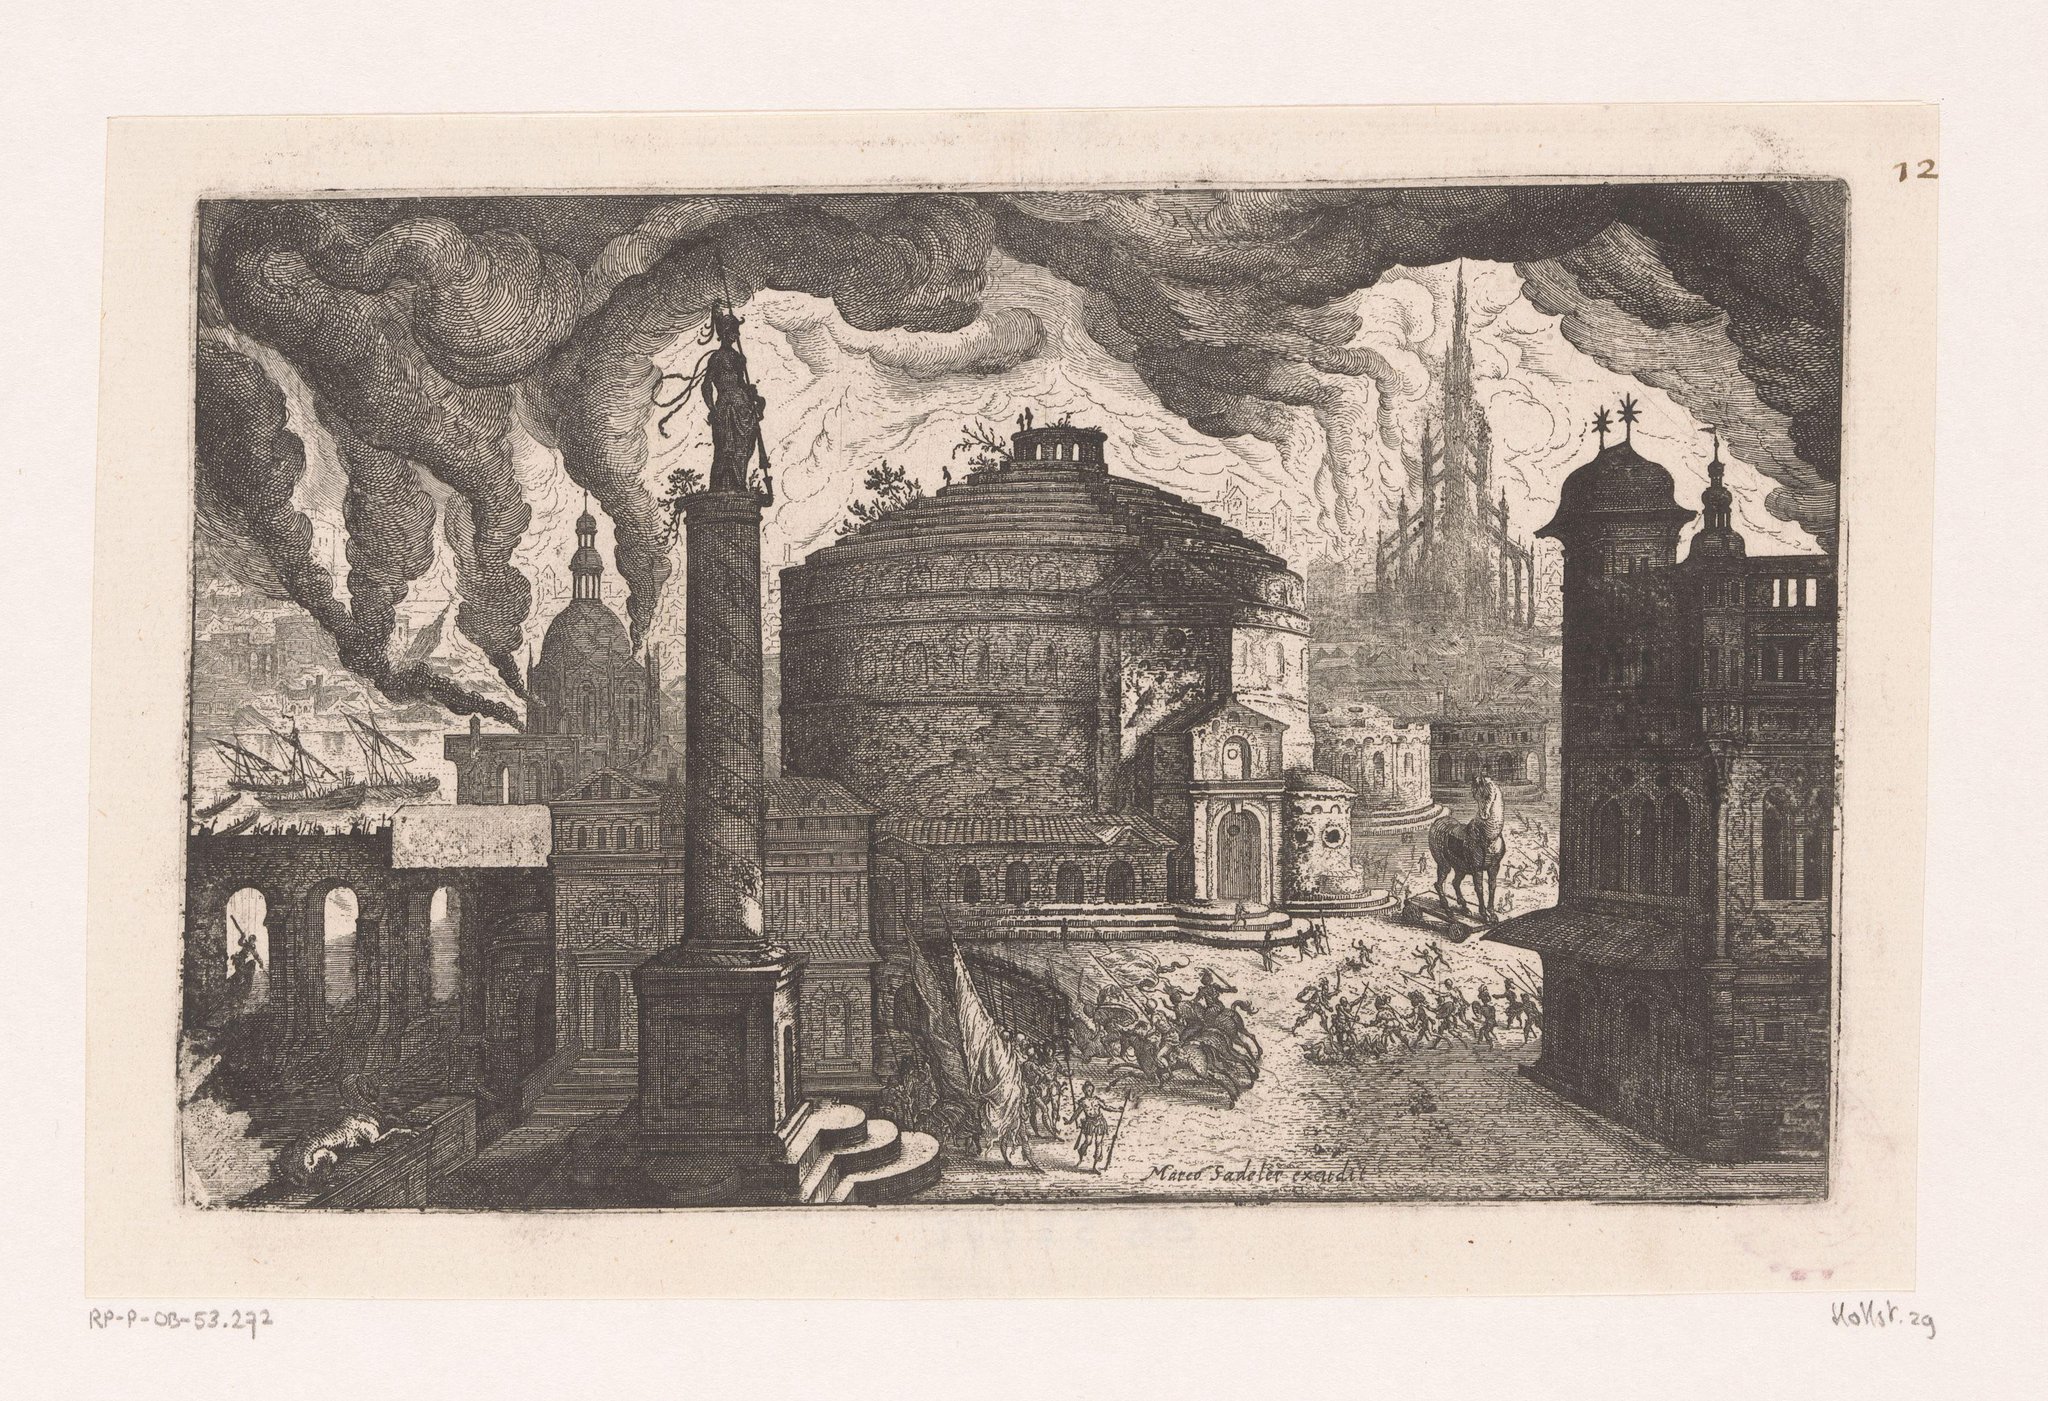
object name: print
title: Paard van Troje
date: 1586-1630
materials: paper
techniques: engraving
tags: the trojan horse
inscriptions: collector's mark: Lugt 240